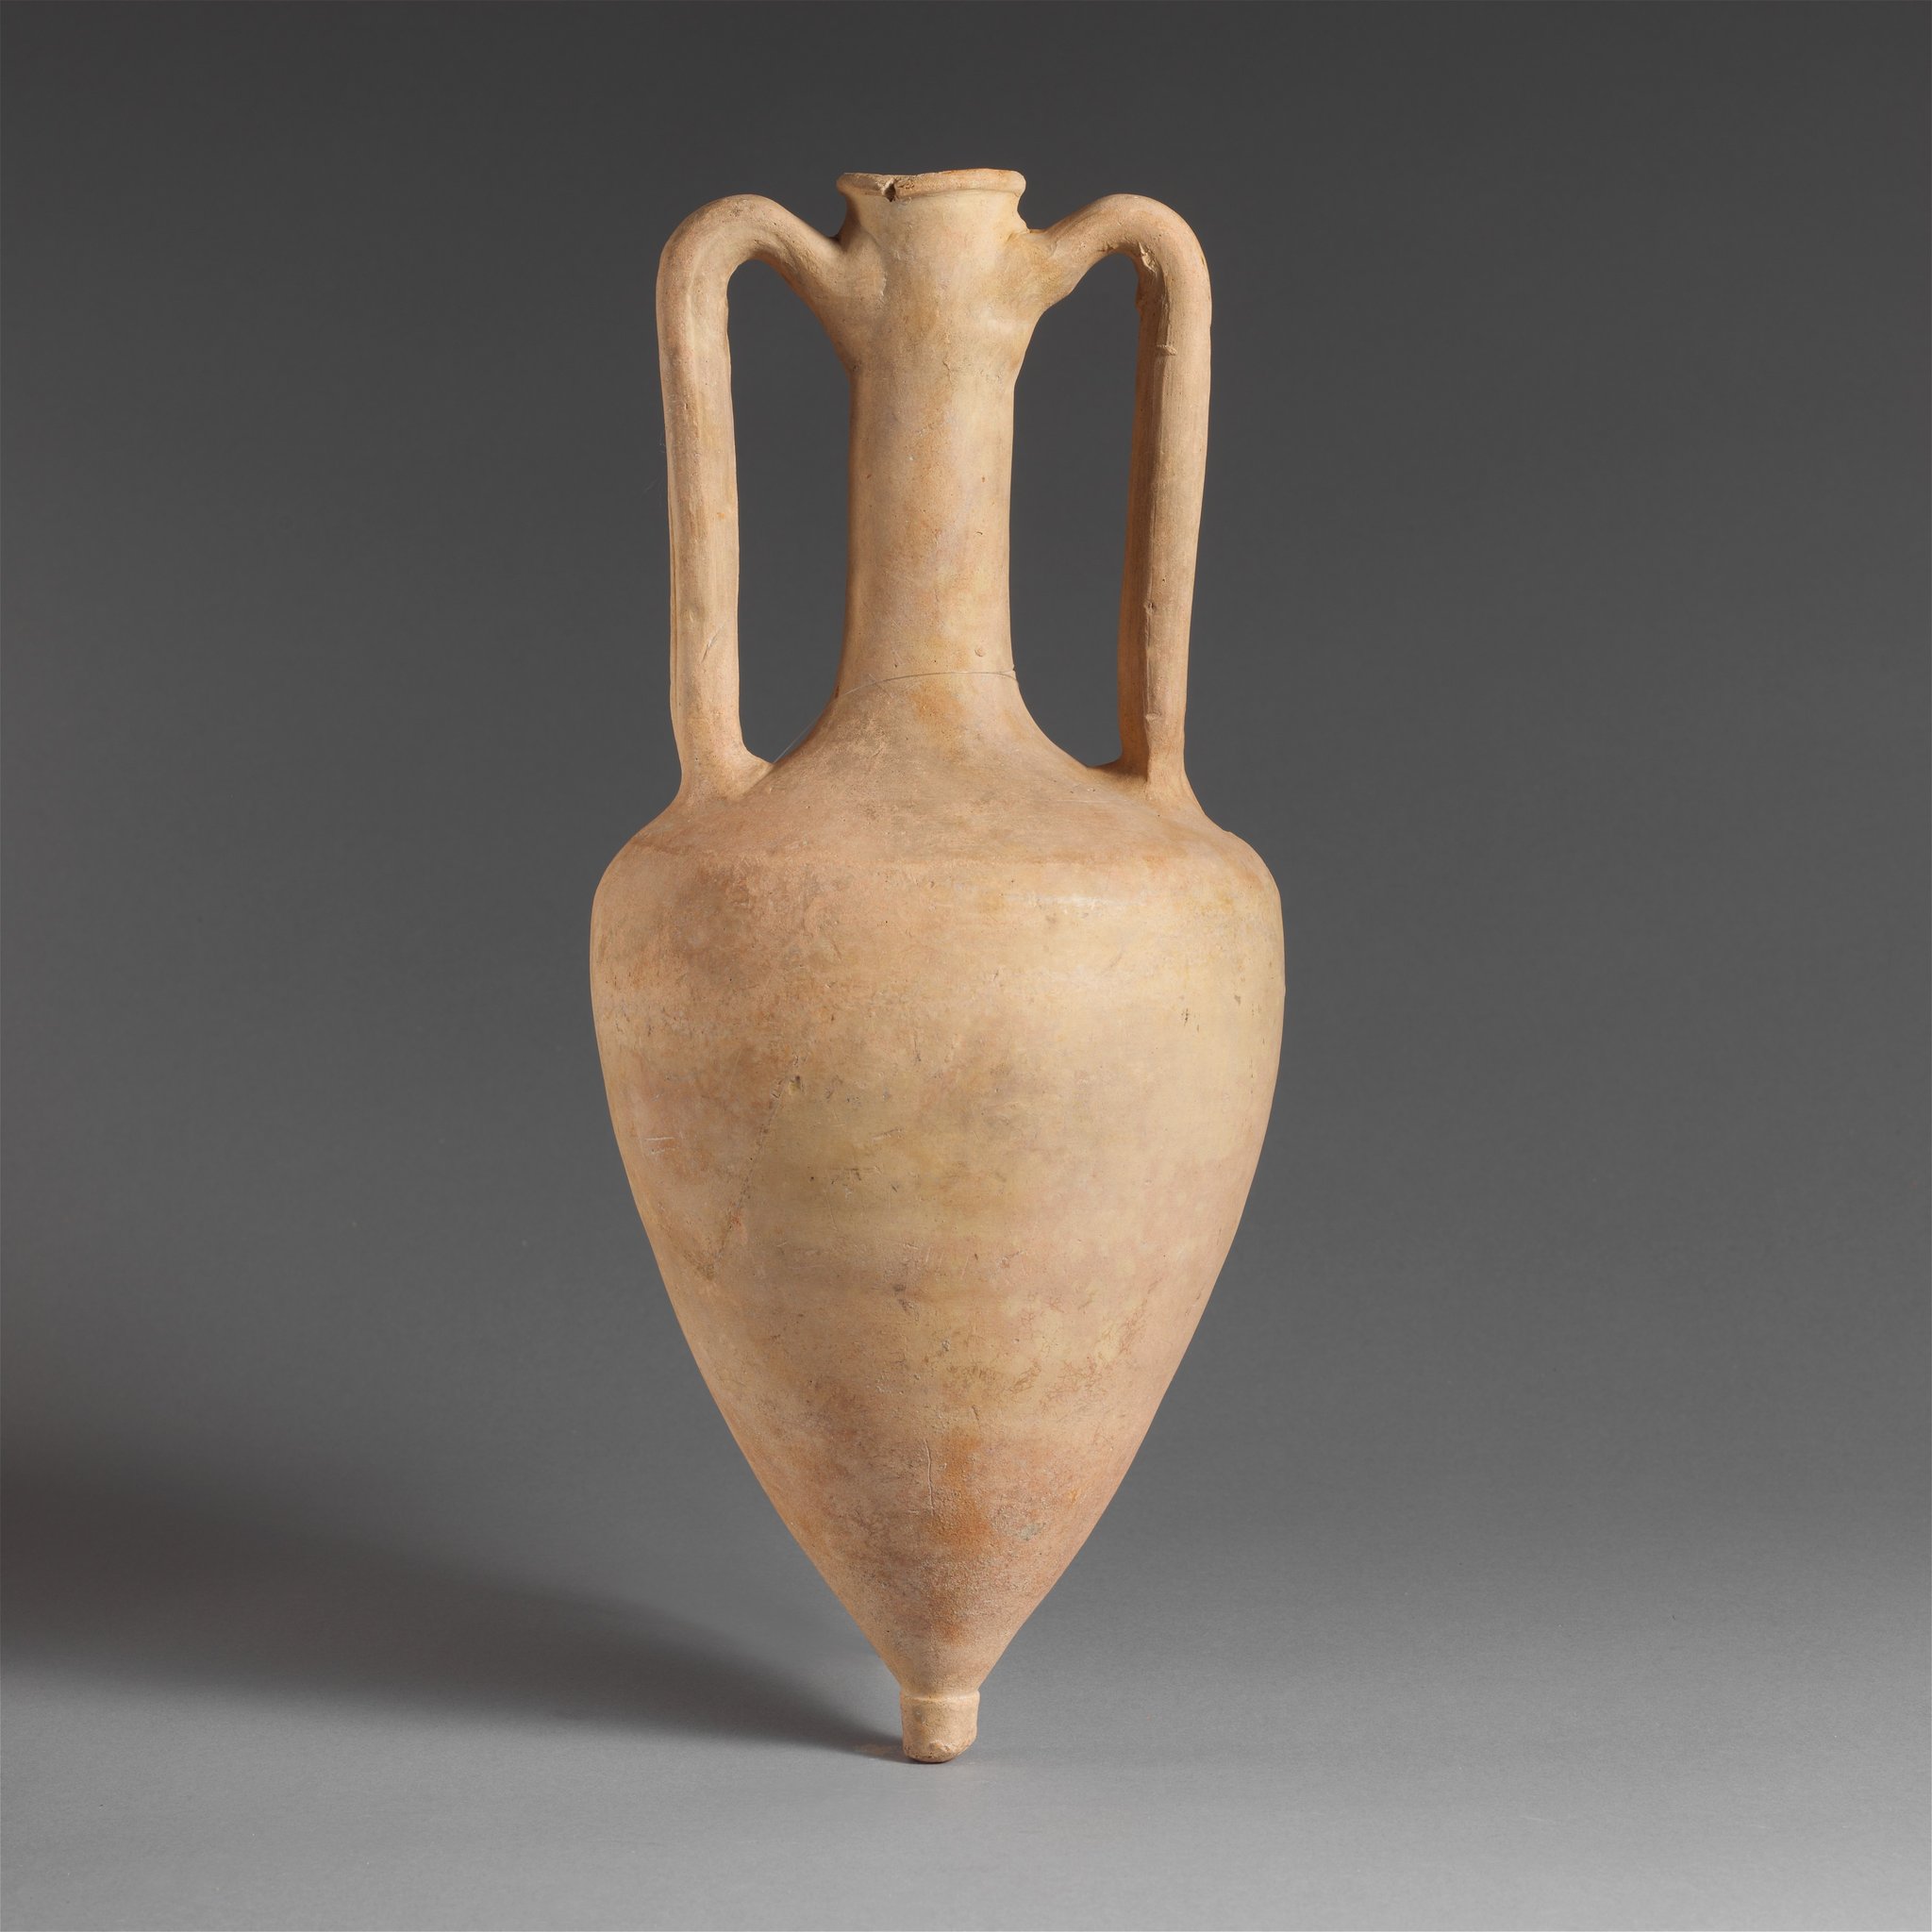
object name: amphora, pointed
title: Terracotta amphora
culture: greek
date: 300-201 BCE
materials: terracotta